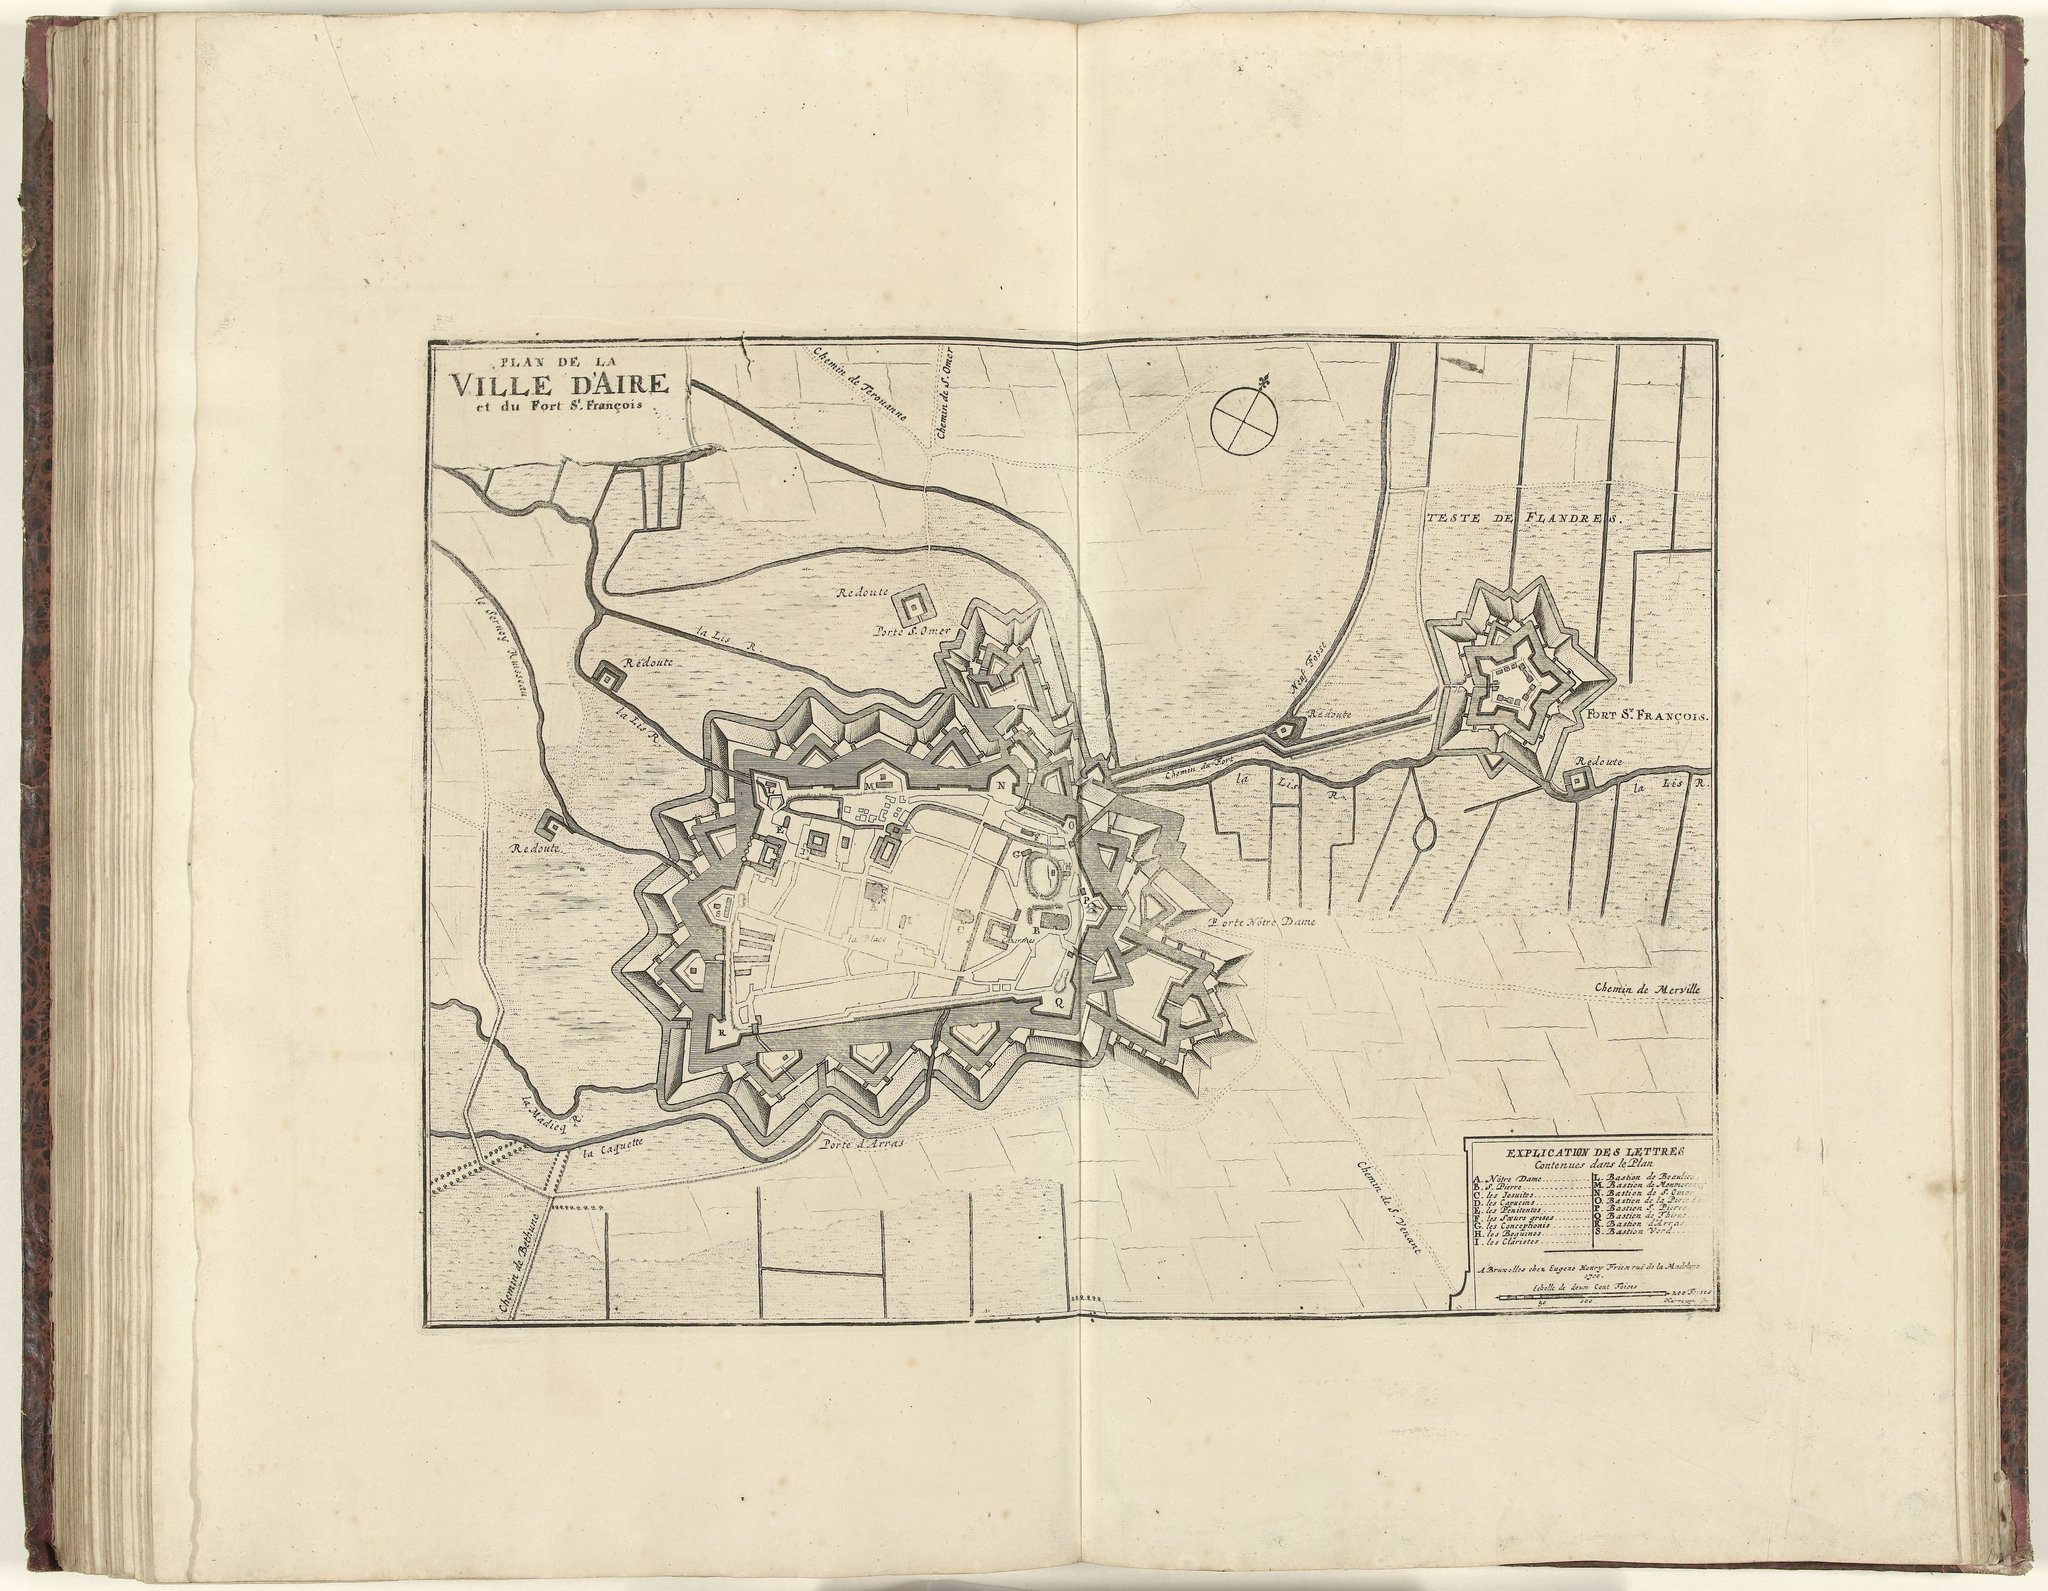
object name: print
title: Plattegrond van Aire, 1710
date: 1710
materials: paper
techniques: etching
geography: brussels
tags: maps of cities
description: Plattegrond van de versterkingen om de stad Aire en het Fort St. François, belegerd en ingenomen door de Geallieerden in 1710. Rechtsonder een cartouche met de legenda A-S in het Frans. Onderdeel van een gebundelde verzameling van plannen van veldslagen en steden vermaard in de Spaanse Successieoorlog.